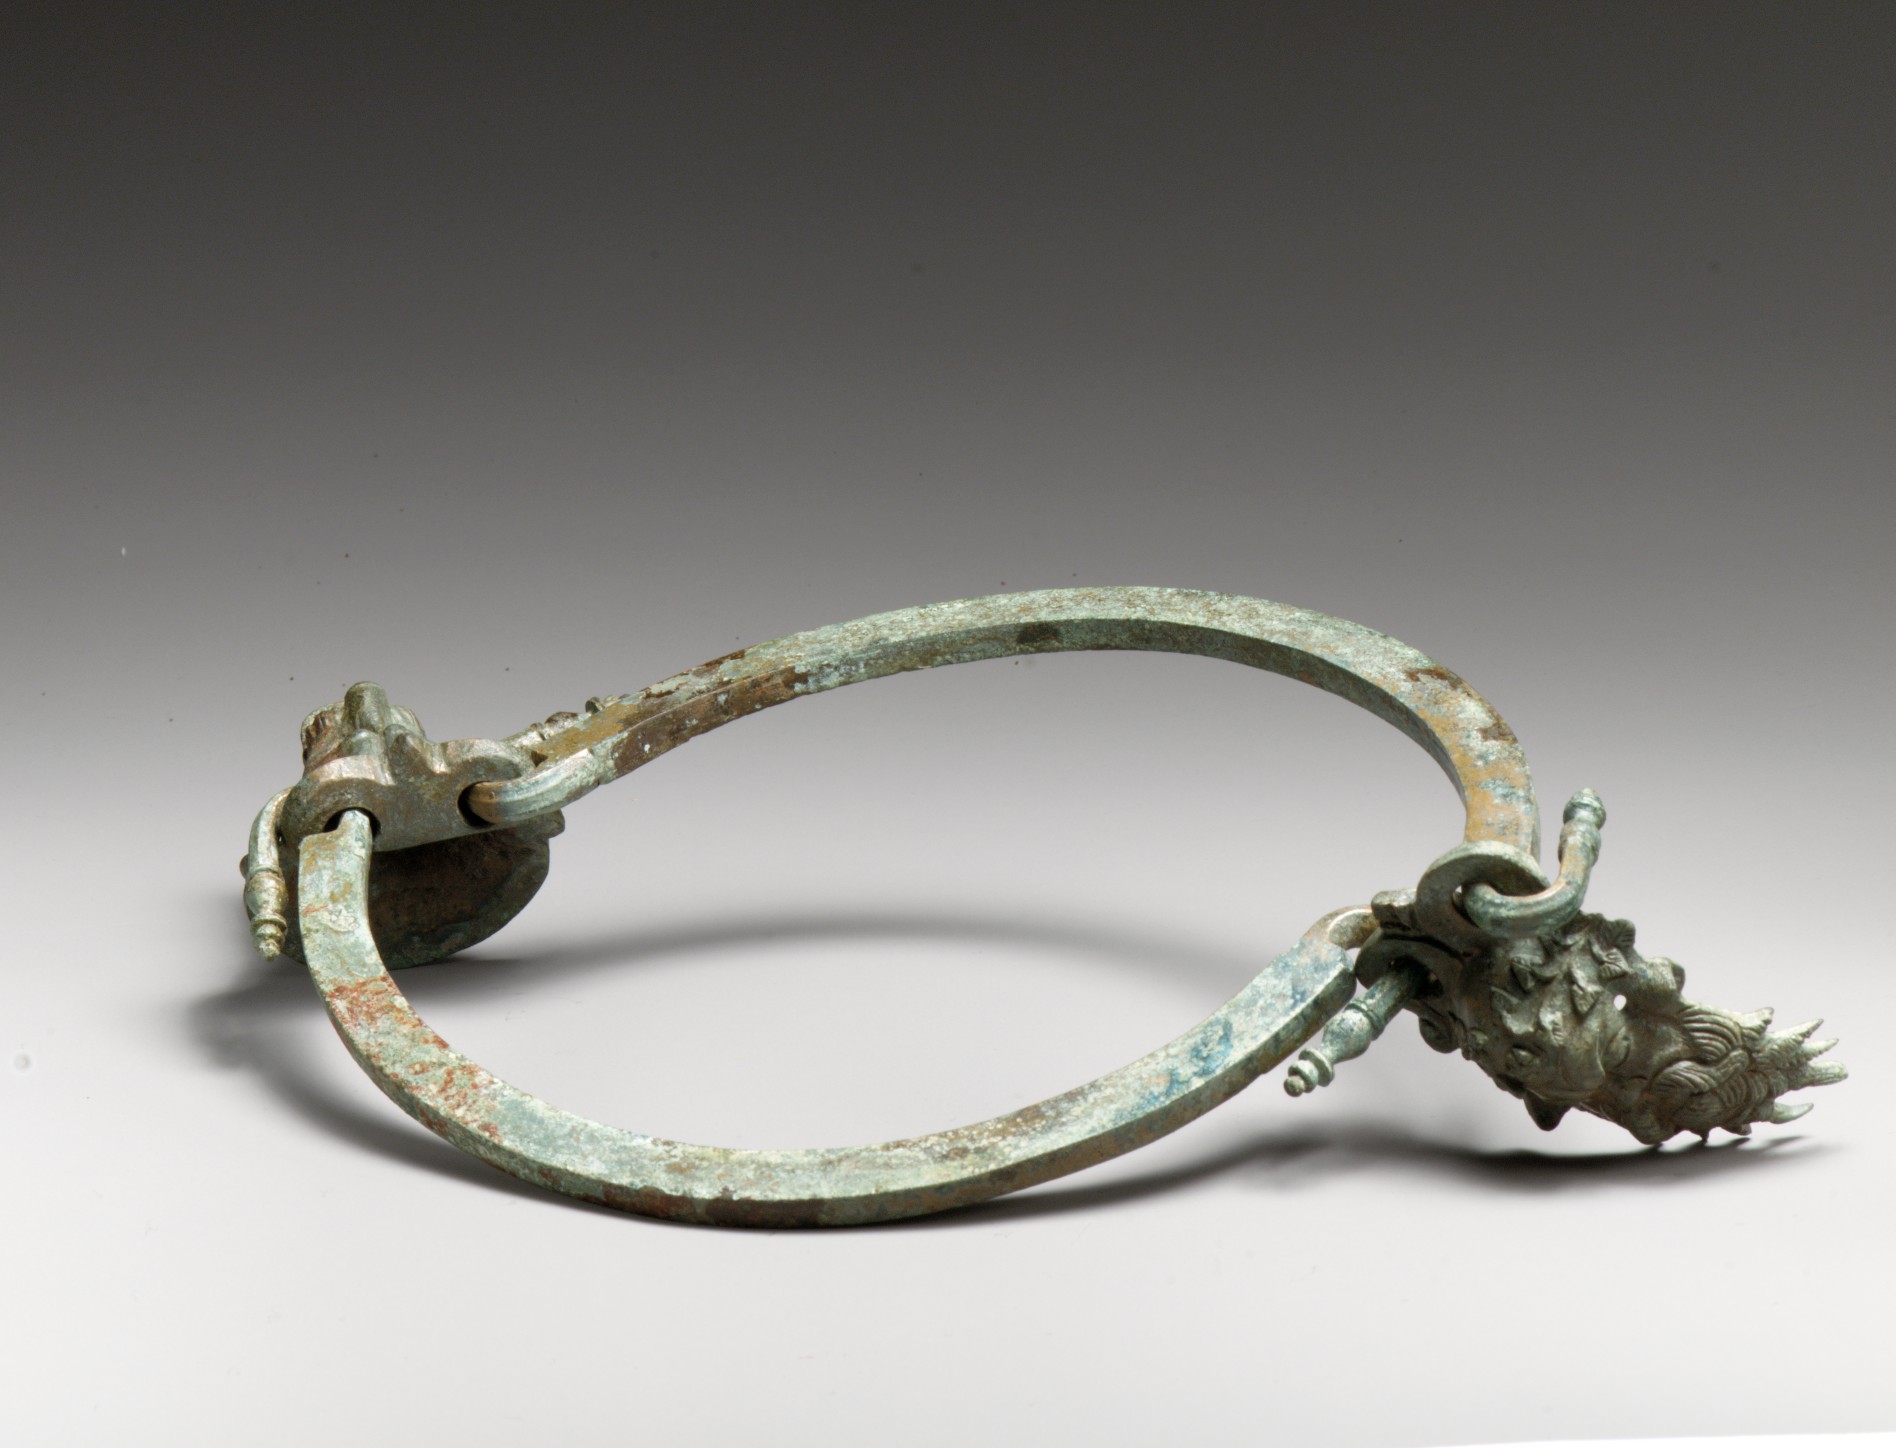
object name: handle of a situla with satyr head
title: Bronze handle of a situla (pail) with Silenos head attachment and lion head mouthpiece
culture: etruscan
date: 400-301 BCE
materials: bronze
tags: silenus,lions